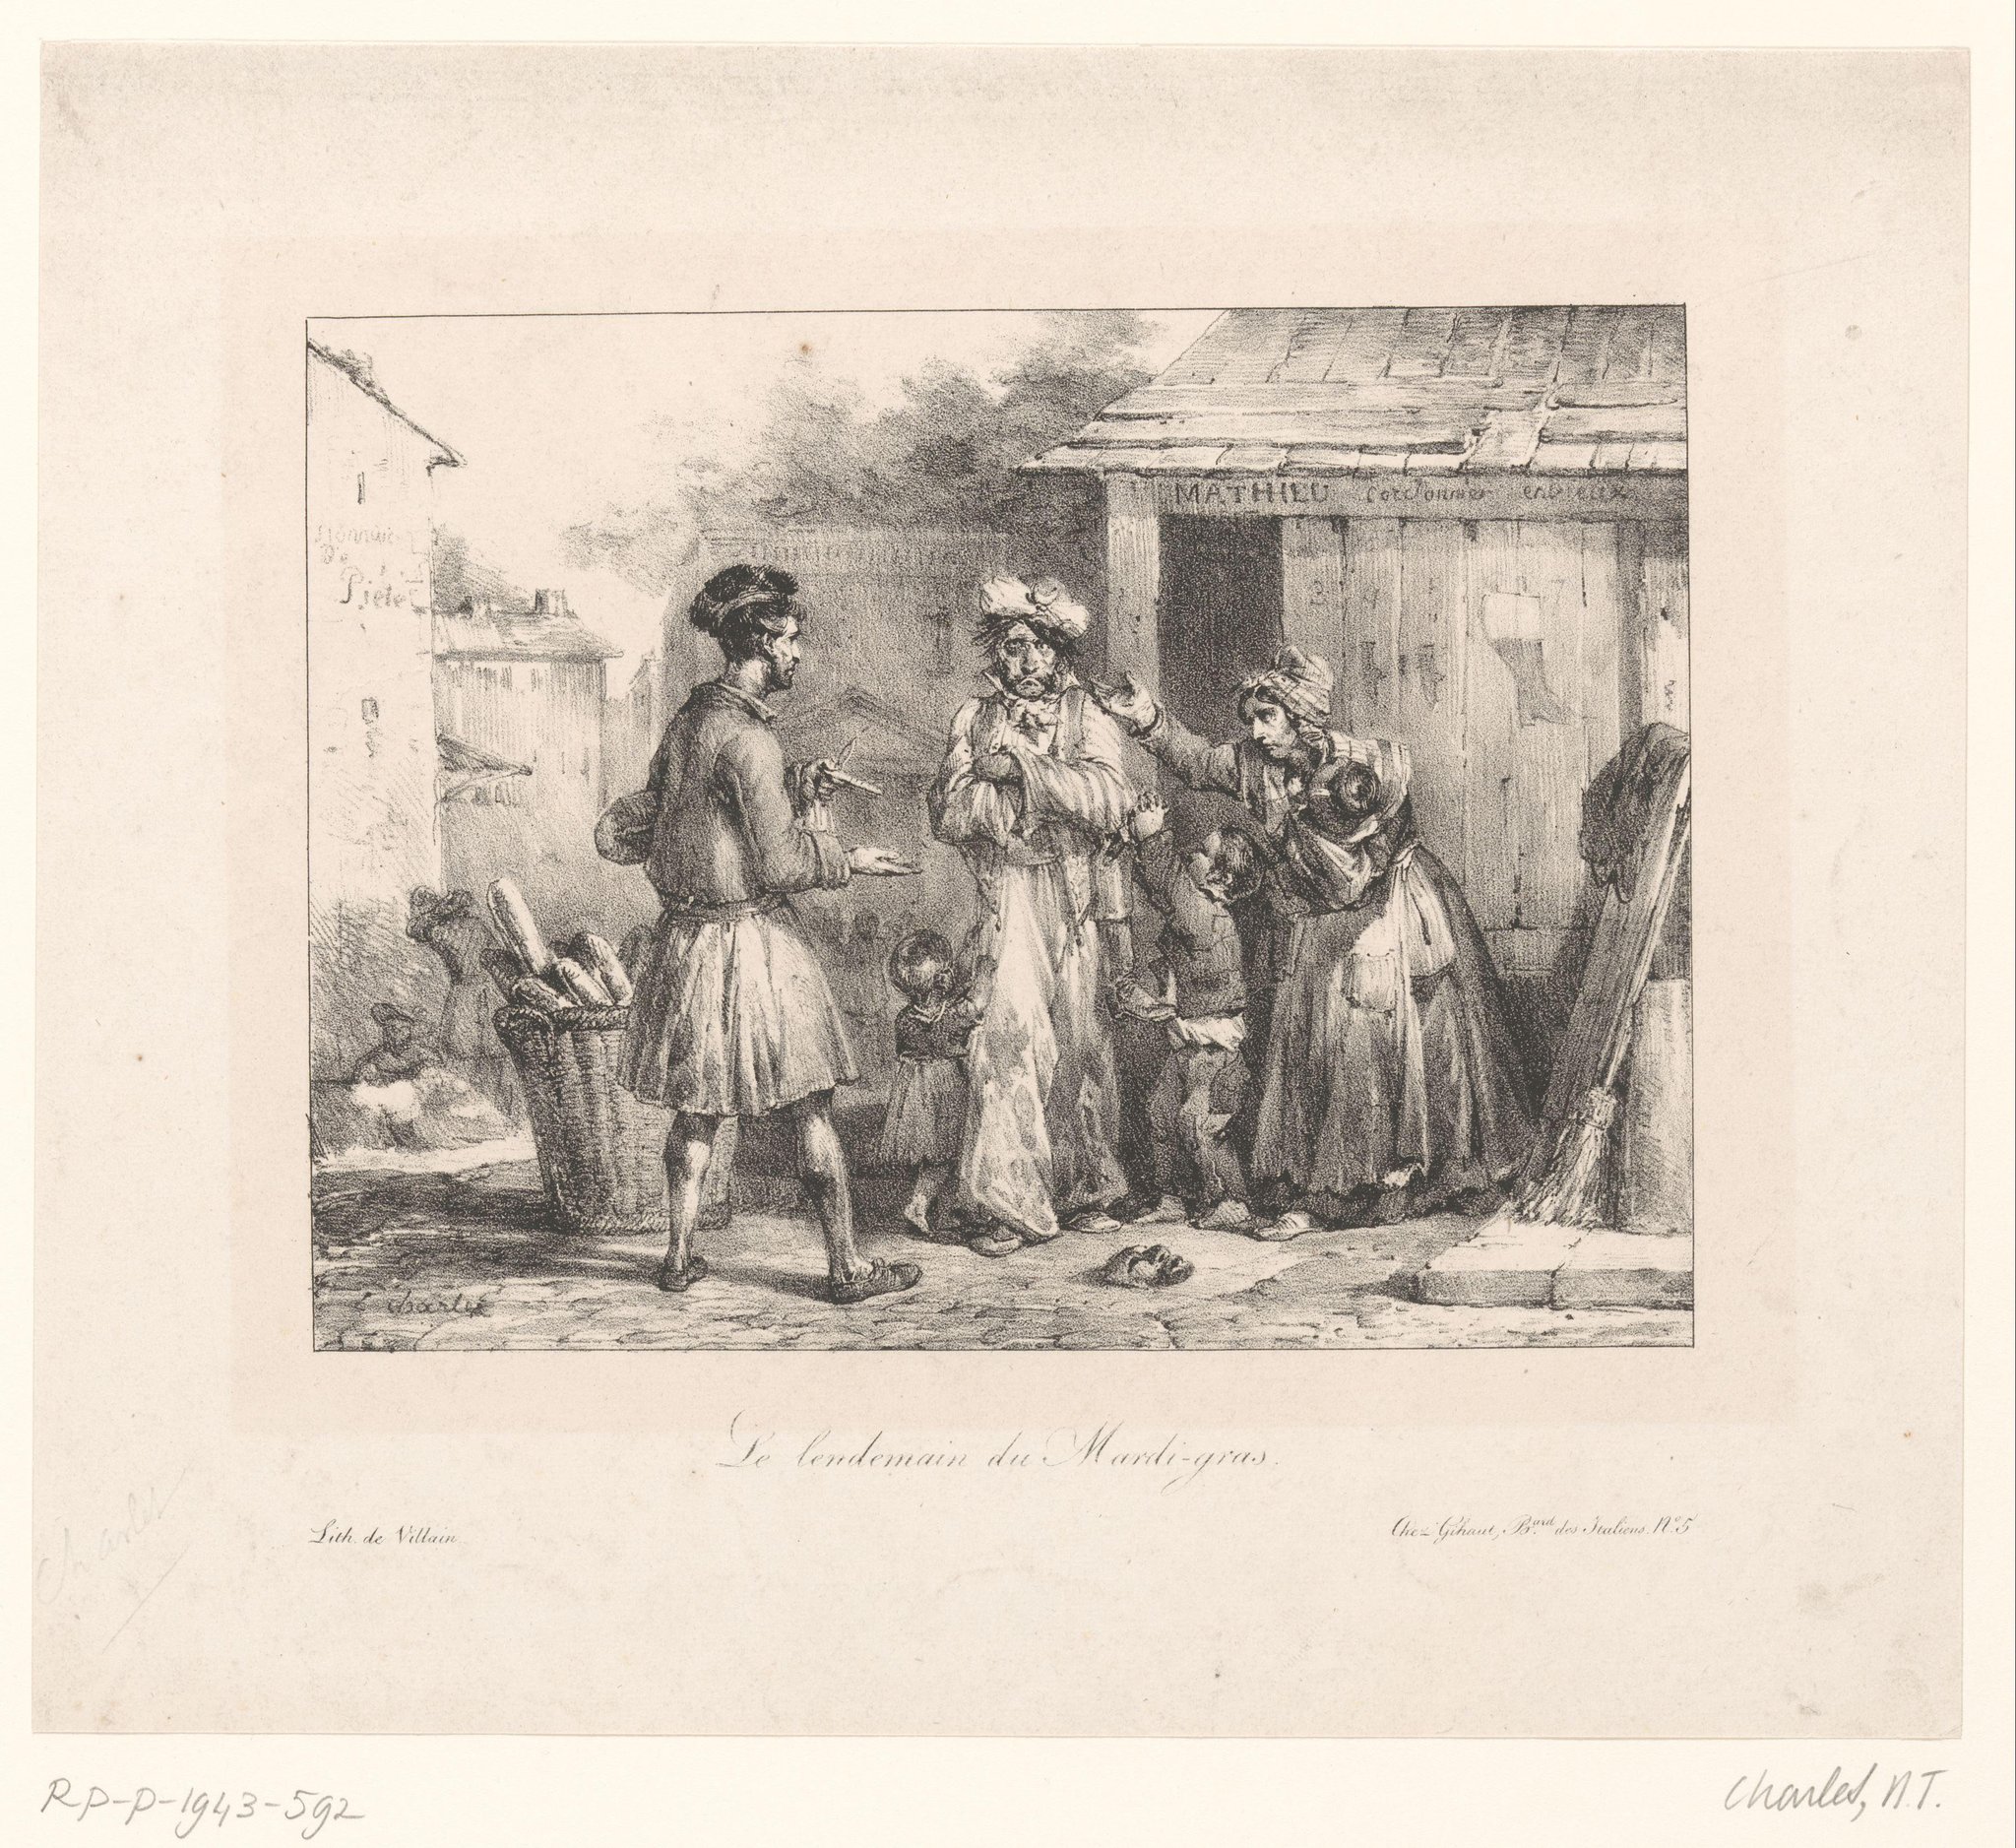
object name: print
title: Le lendemain du Mardi-Gras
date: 1824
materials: paper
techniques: lithograph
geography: paris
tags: baker, shrove tuesday, 'mardi gras' ~ non-liturgical celebrations of carnival, father and child(ren), man and child(ren) (family group)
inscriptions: collector's mark: Lugt 2228a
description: Een arme schoenmaker is na het feest van Vastenavond, nog in zijn carnavalskostuum, teruggekeerd naar huis. Zijn vrouw en kinderen willen graag brood kopen van de bakker die langs de deur komt, maar het geld is allemaal op.